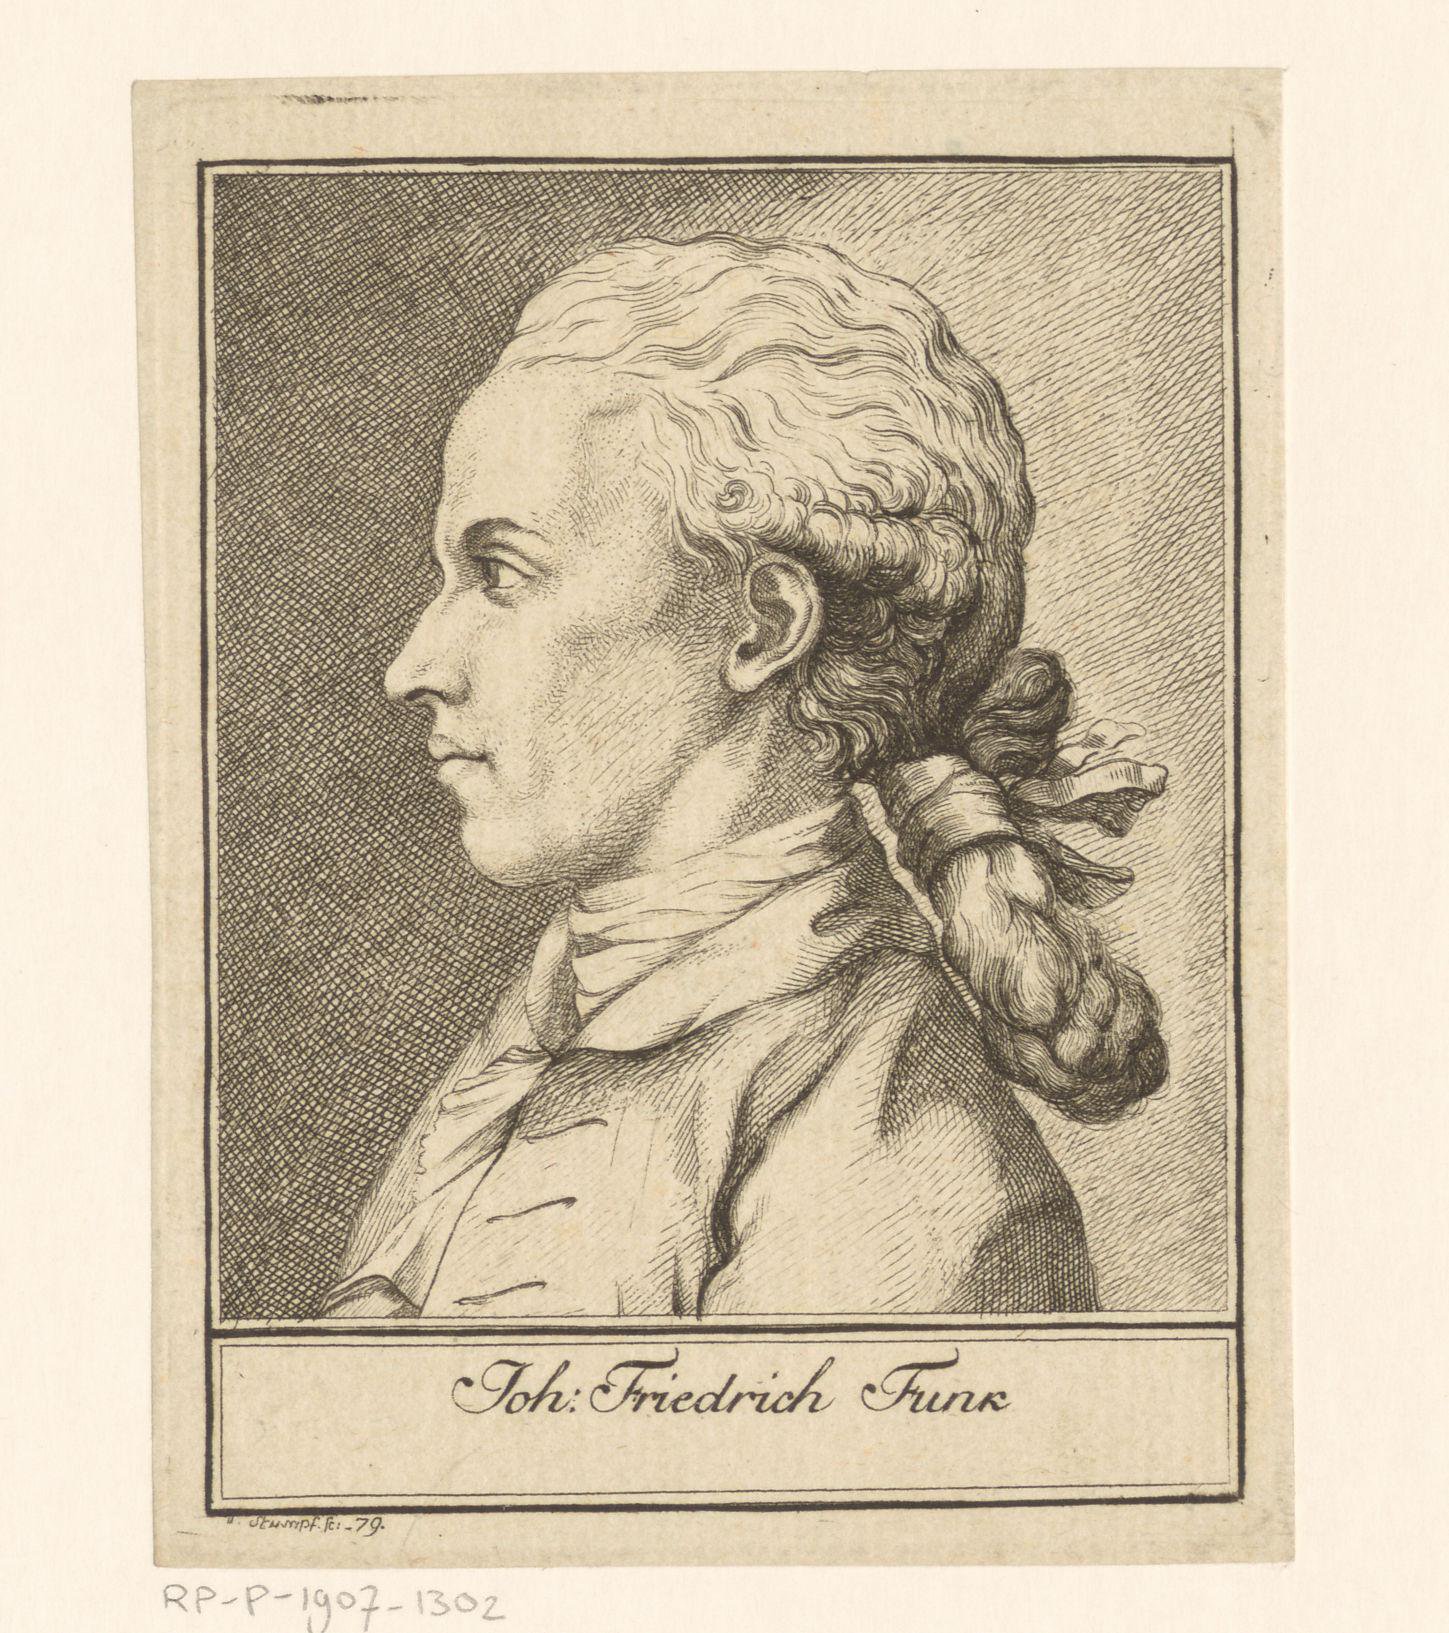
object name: print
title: Portret van Johann Friedrich Funk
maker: matthias stumpf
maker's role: painter, print maker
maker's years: 1755-1806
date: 1779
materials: paper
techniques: etching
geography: zurich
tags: sculptor, historical persons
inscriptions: collector's mark: Lugt 2228